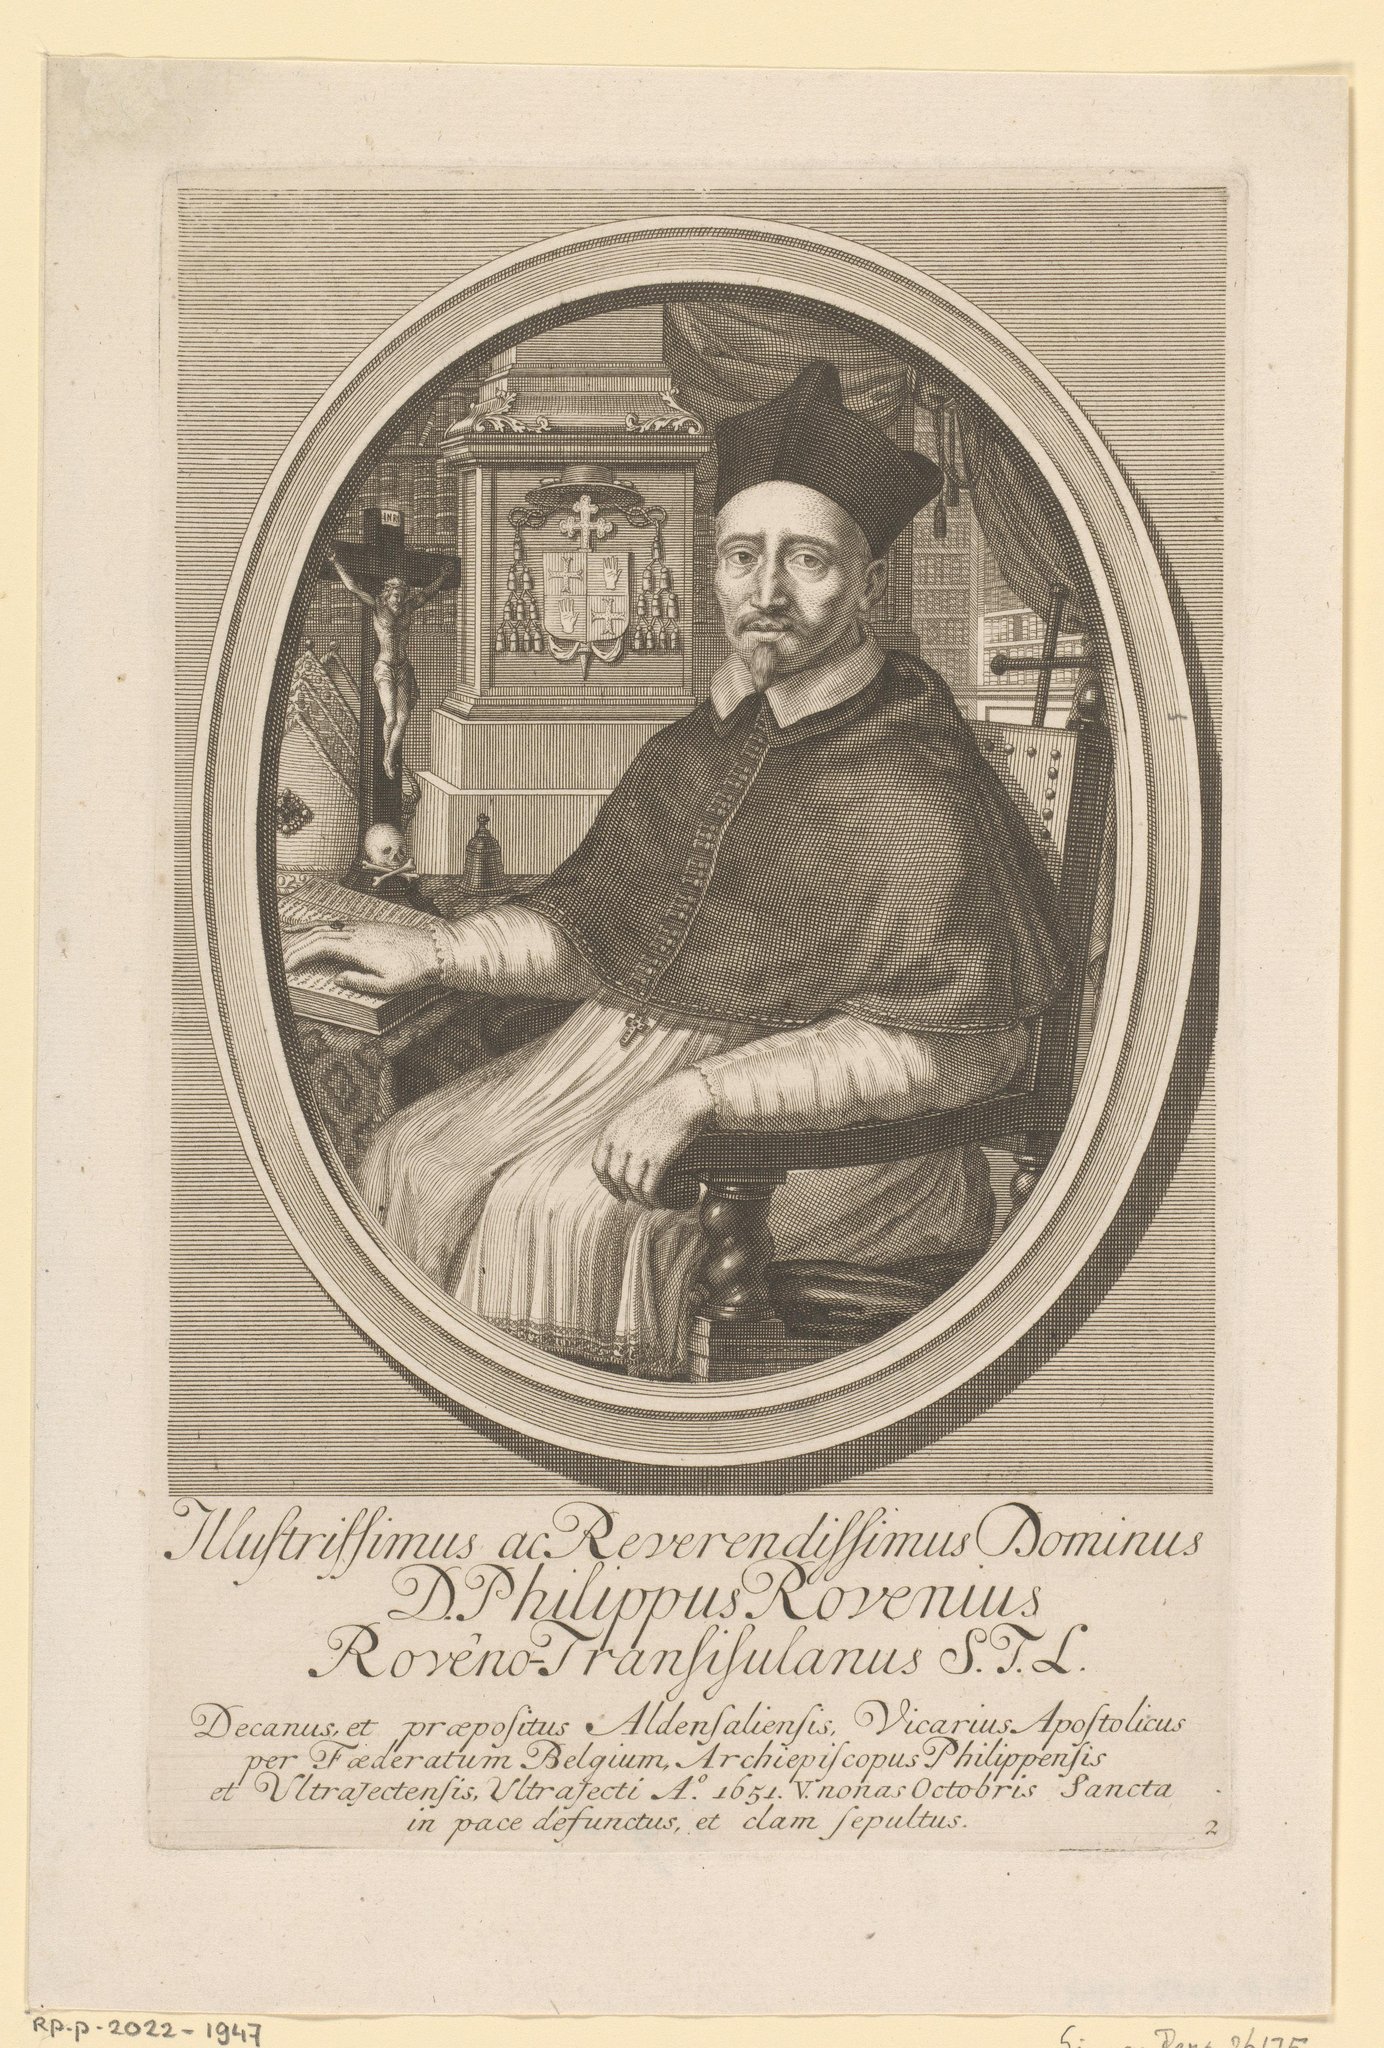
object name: print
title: Portret van Filips van Rouveen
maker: françois van bleyswijck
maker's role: draughtsman, print maker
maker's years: 1671-1746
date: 1681-1726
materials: paper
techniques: engraving, etching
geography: leiden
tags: deventer, utrecht, clergyman, historical persons, organization, functionaries and dignitaries in roman catholic church; clergy in general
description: Prent ook als boekillustratie gebruikt in: Heussen, Hugo Franciscus van en Hugo van Rijn. Kerkelijke historie en outheden der Zeven Vereenigde Provincien. 6 dln. Leiden: Dirk Haak, Samuel Luchtmans en Johan Arnold Langerak, 1726.